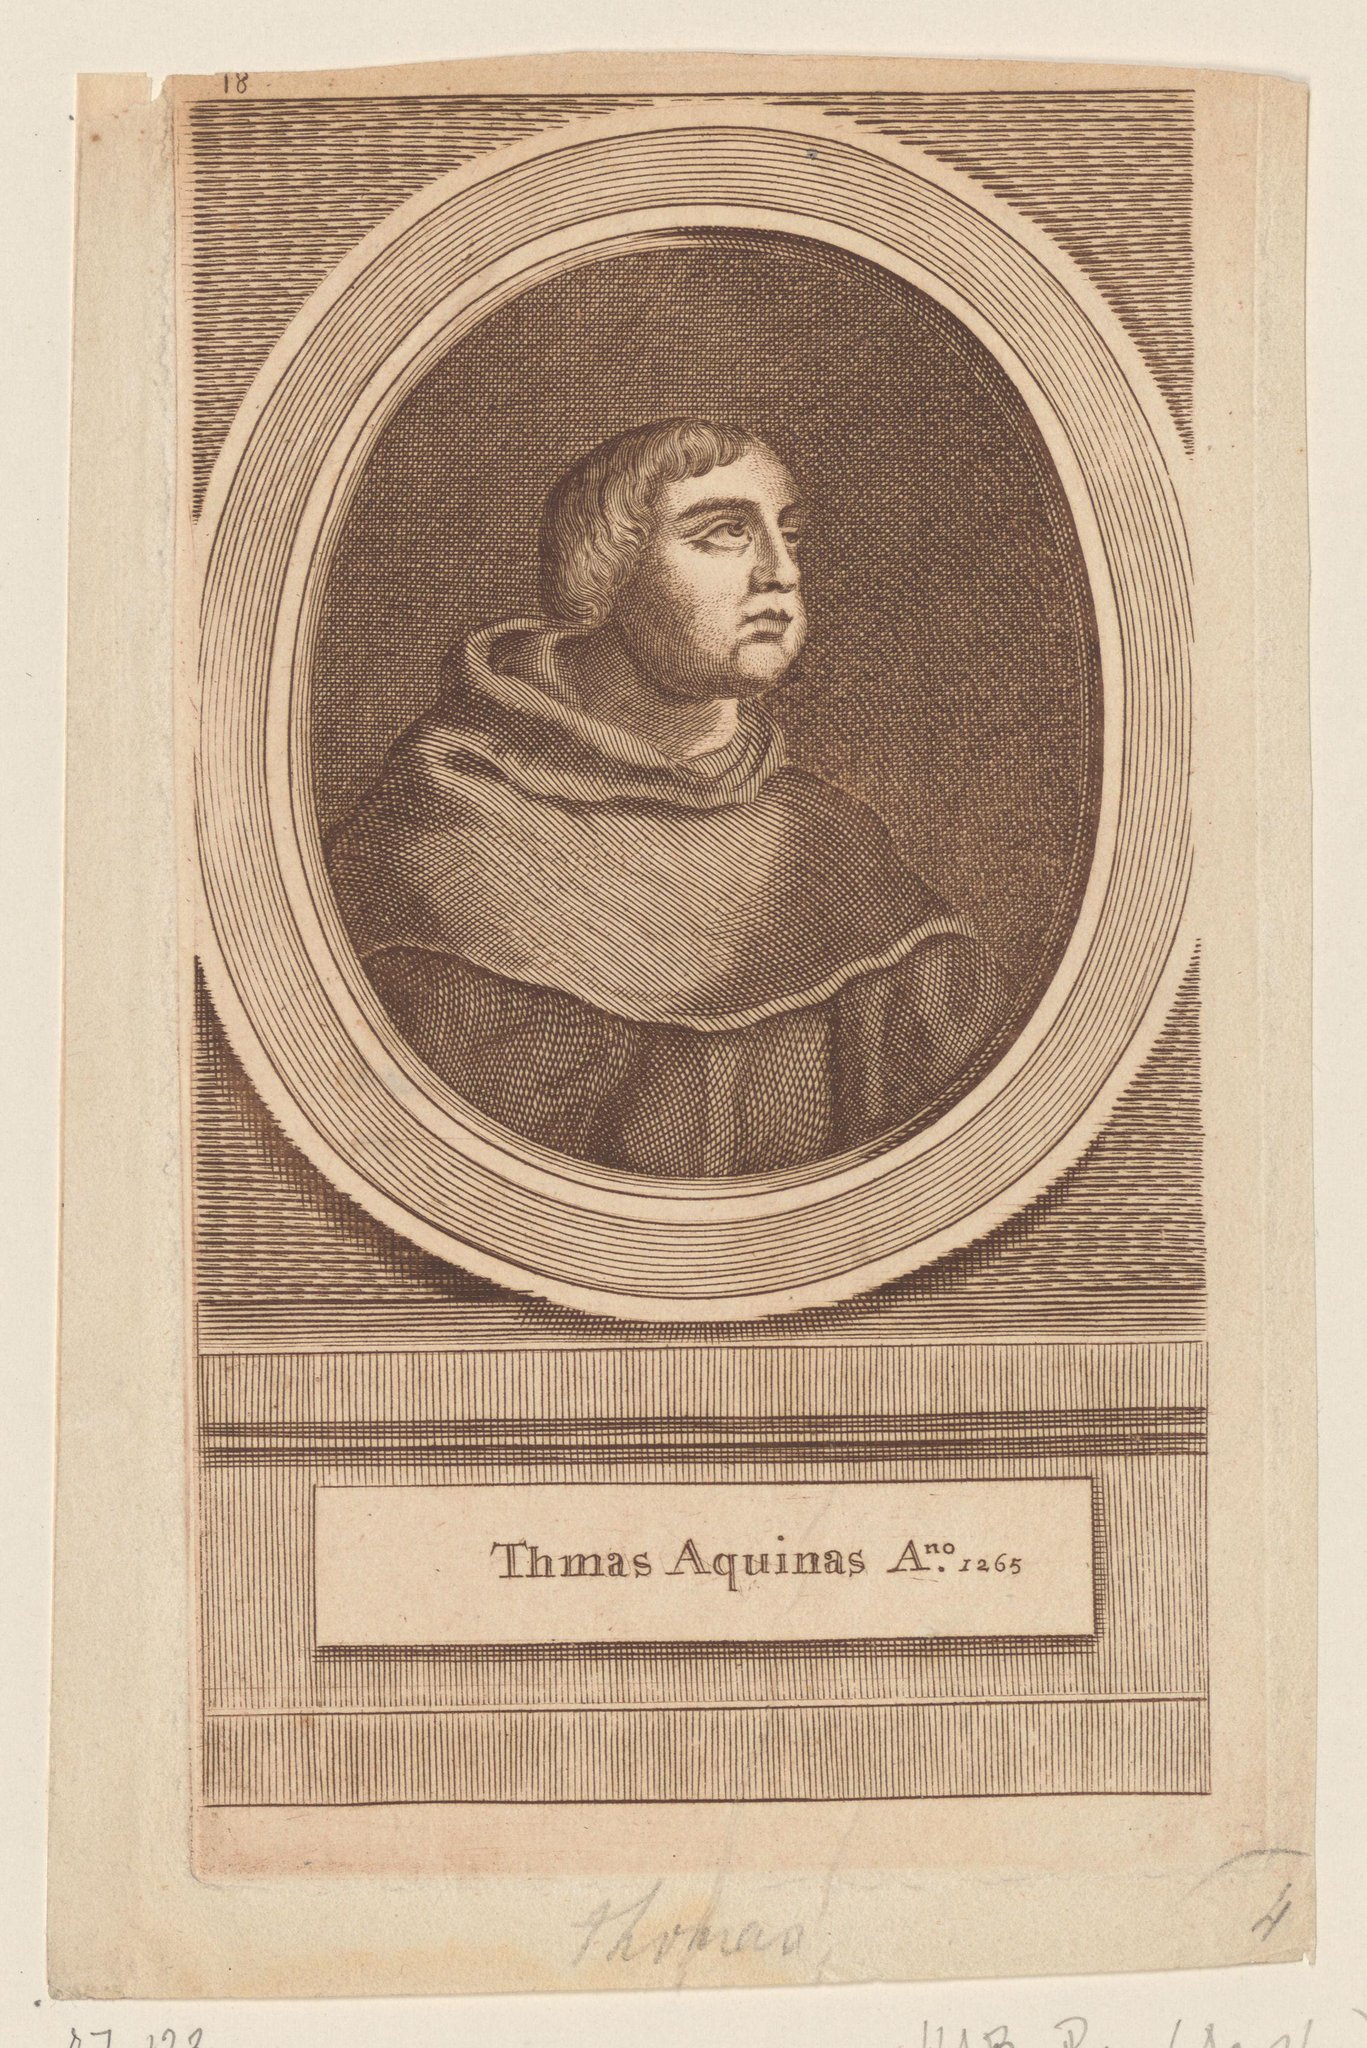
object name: print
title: Portret van Thomas Aquino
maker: Anonymous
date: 1650-1749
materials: paper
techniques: engraving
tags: thomas van aquino, historical persons, the dominican theologian, 'angelic doctor' thomas of aquino; possible attributes: book, (chain with) sun, dove, girdle of chastity, lily, model of church, monstrance (or chalice), mitre (under feet), star (on breast)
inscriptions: collector's mark: Lugt 2228